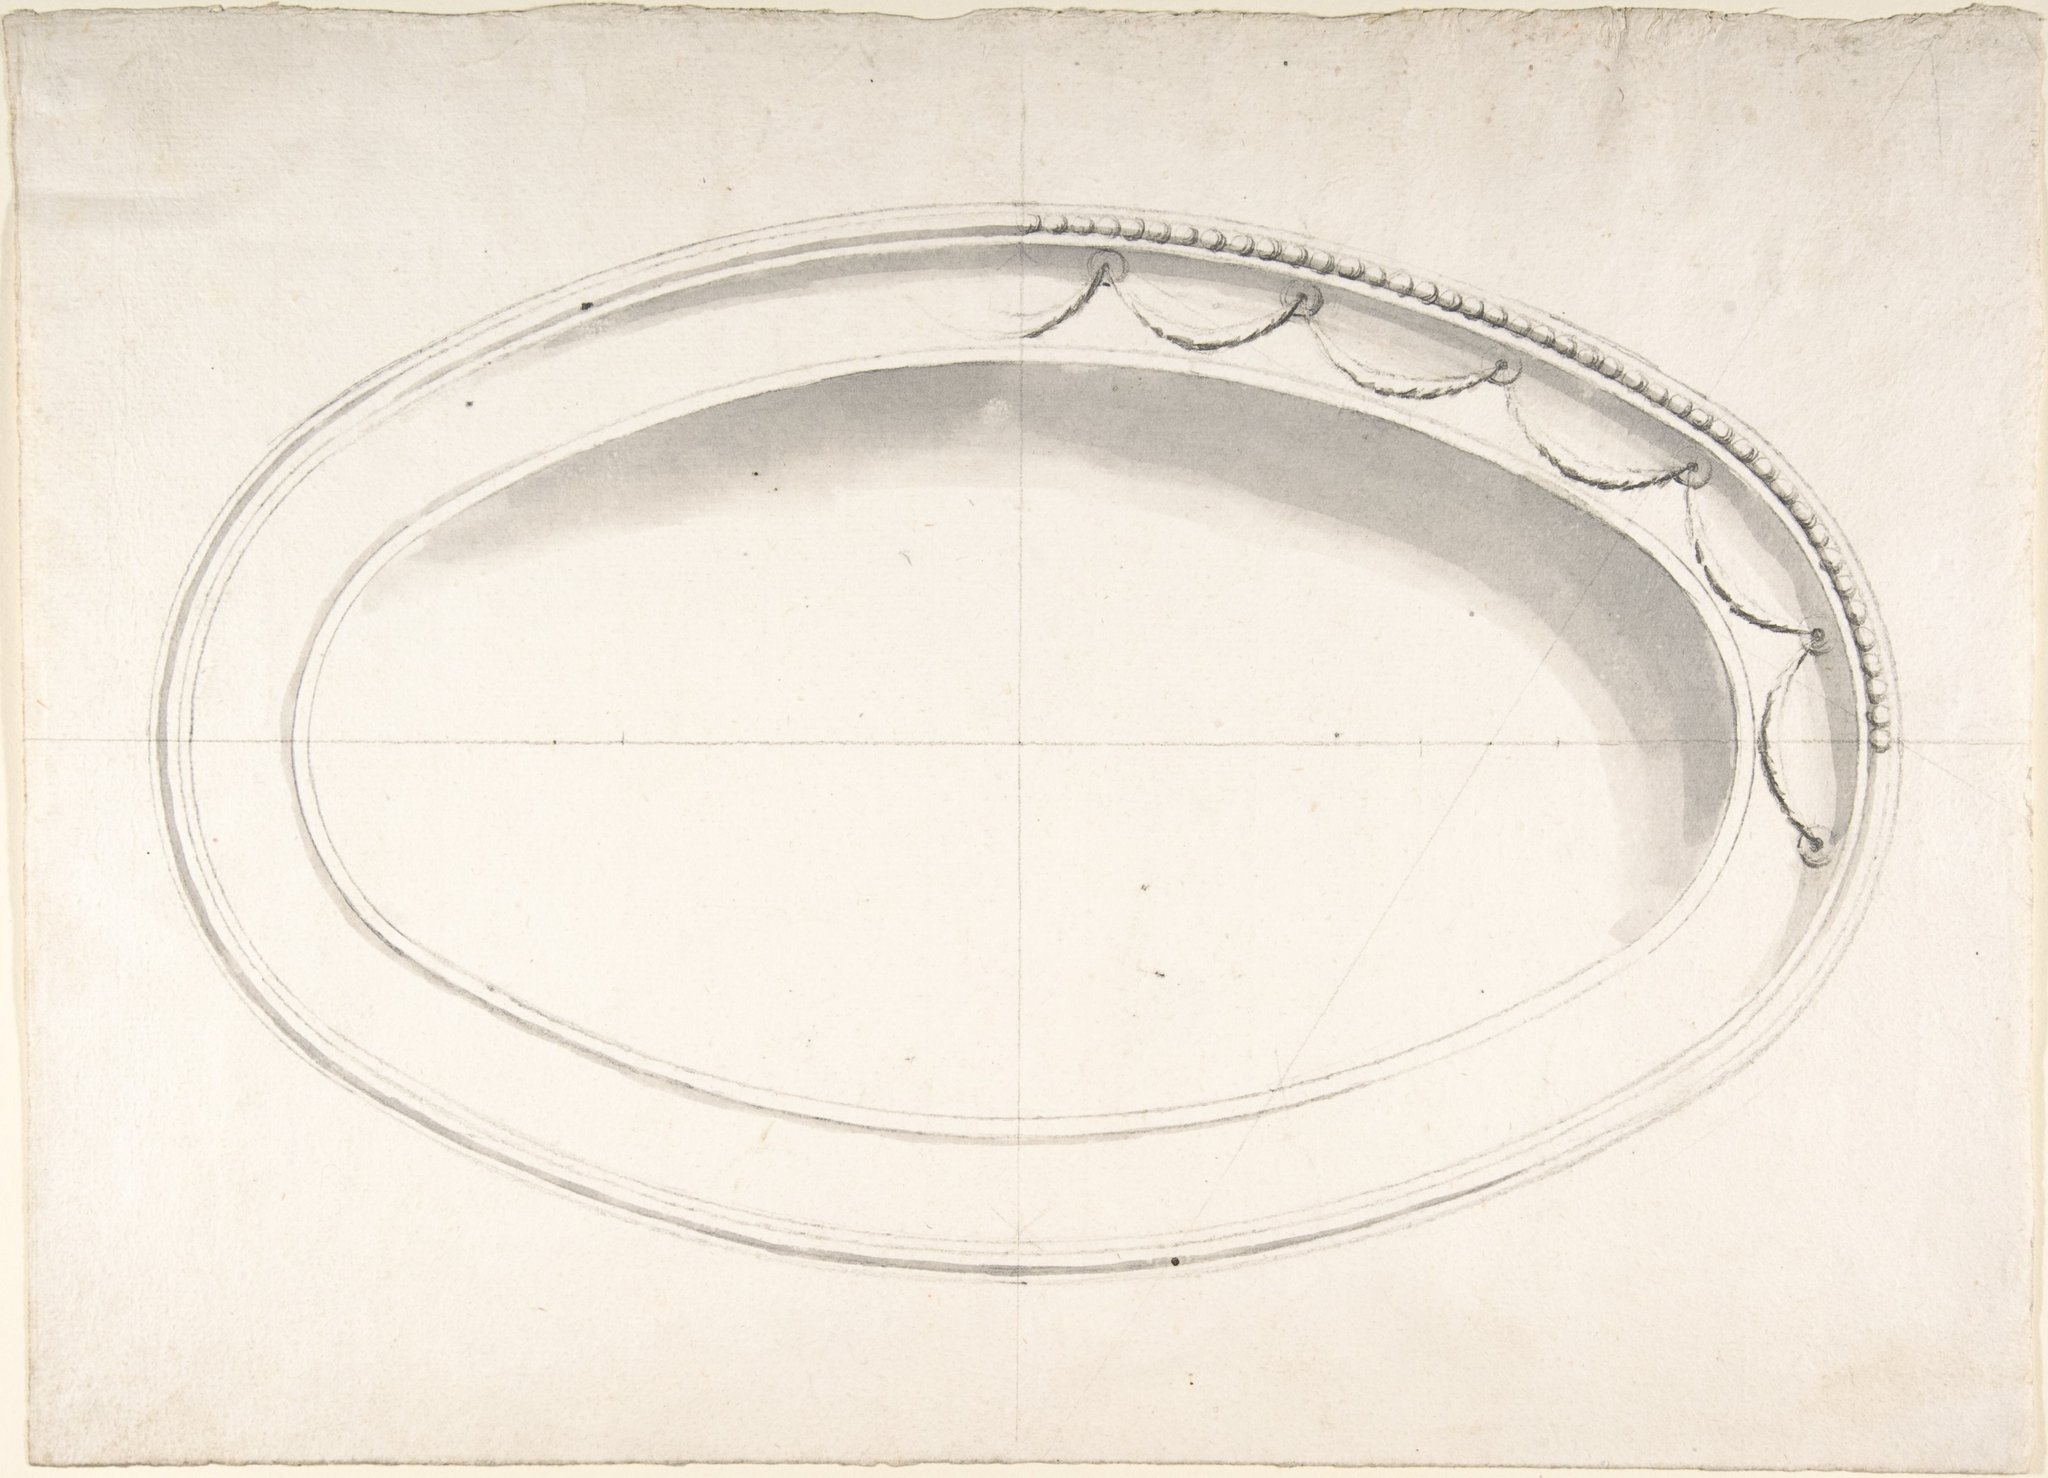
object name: drawing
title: Oval Dish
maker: anonymous, italian, 19th century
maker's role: artist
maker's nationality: italian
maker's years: 1800-1900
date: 1800-1900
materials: ink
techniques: pen, wash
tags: dishes